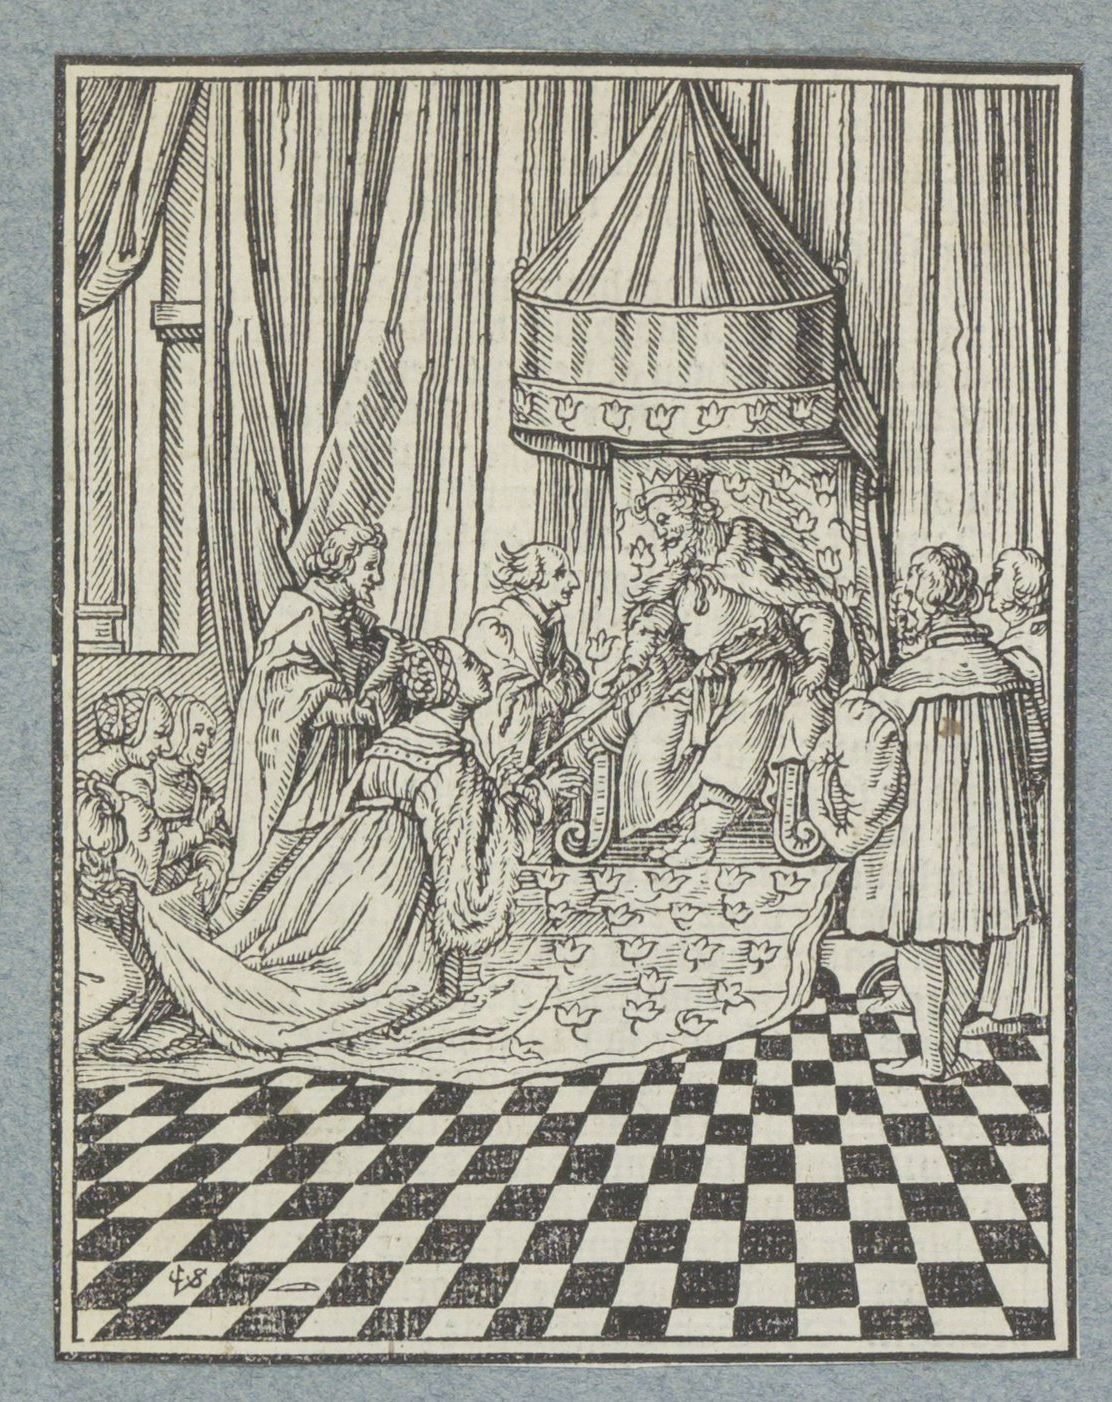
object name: book illustration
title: Ahasveros reikt Ester de gouden scepter aan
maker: pieter jacobsz. paets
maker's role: publisher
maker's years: 1587-1667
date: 1645-1646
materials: paper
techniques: letterpress printing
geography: amsterdam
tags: ahasuerus holds out his sceptre to esther (esther usually kneeling)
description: Het was iedereen verboden om ongevraagd bij koning Ahasveros te verschijnen. Ester trok haar mooiste kleren aan en raapte al haar moed bijeen. Ahasveros reikte haar de gouden scepter toe, ten teken dat hij genegen was haar te ontvangen. Ester ging naar voren en raakte het uiteinde van de scepter aan. De prent maakt deel uit van een album.